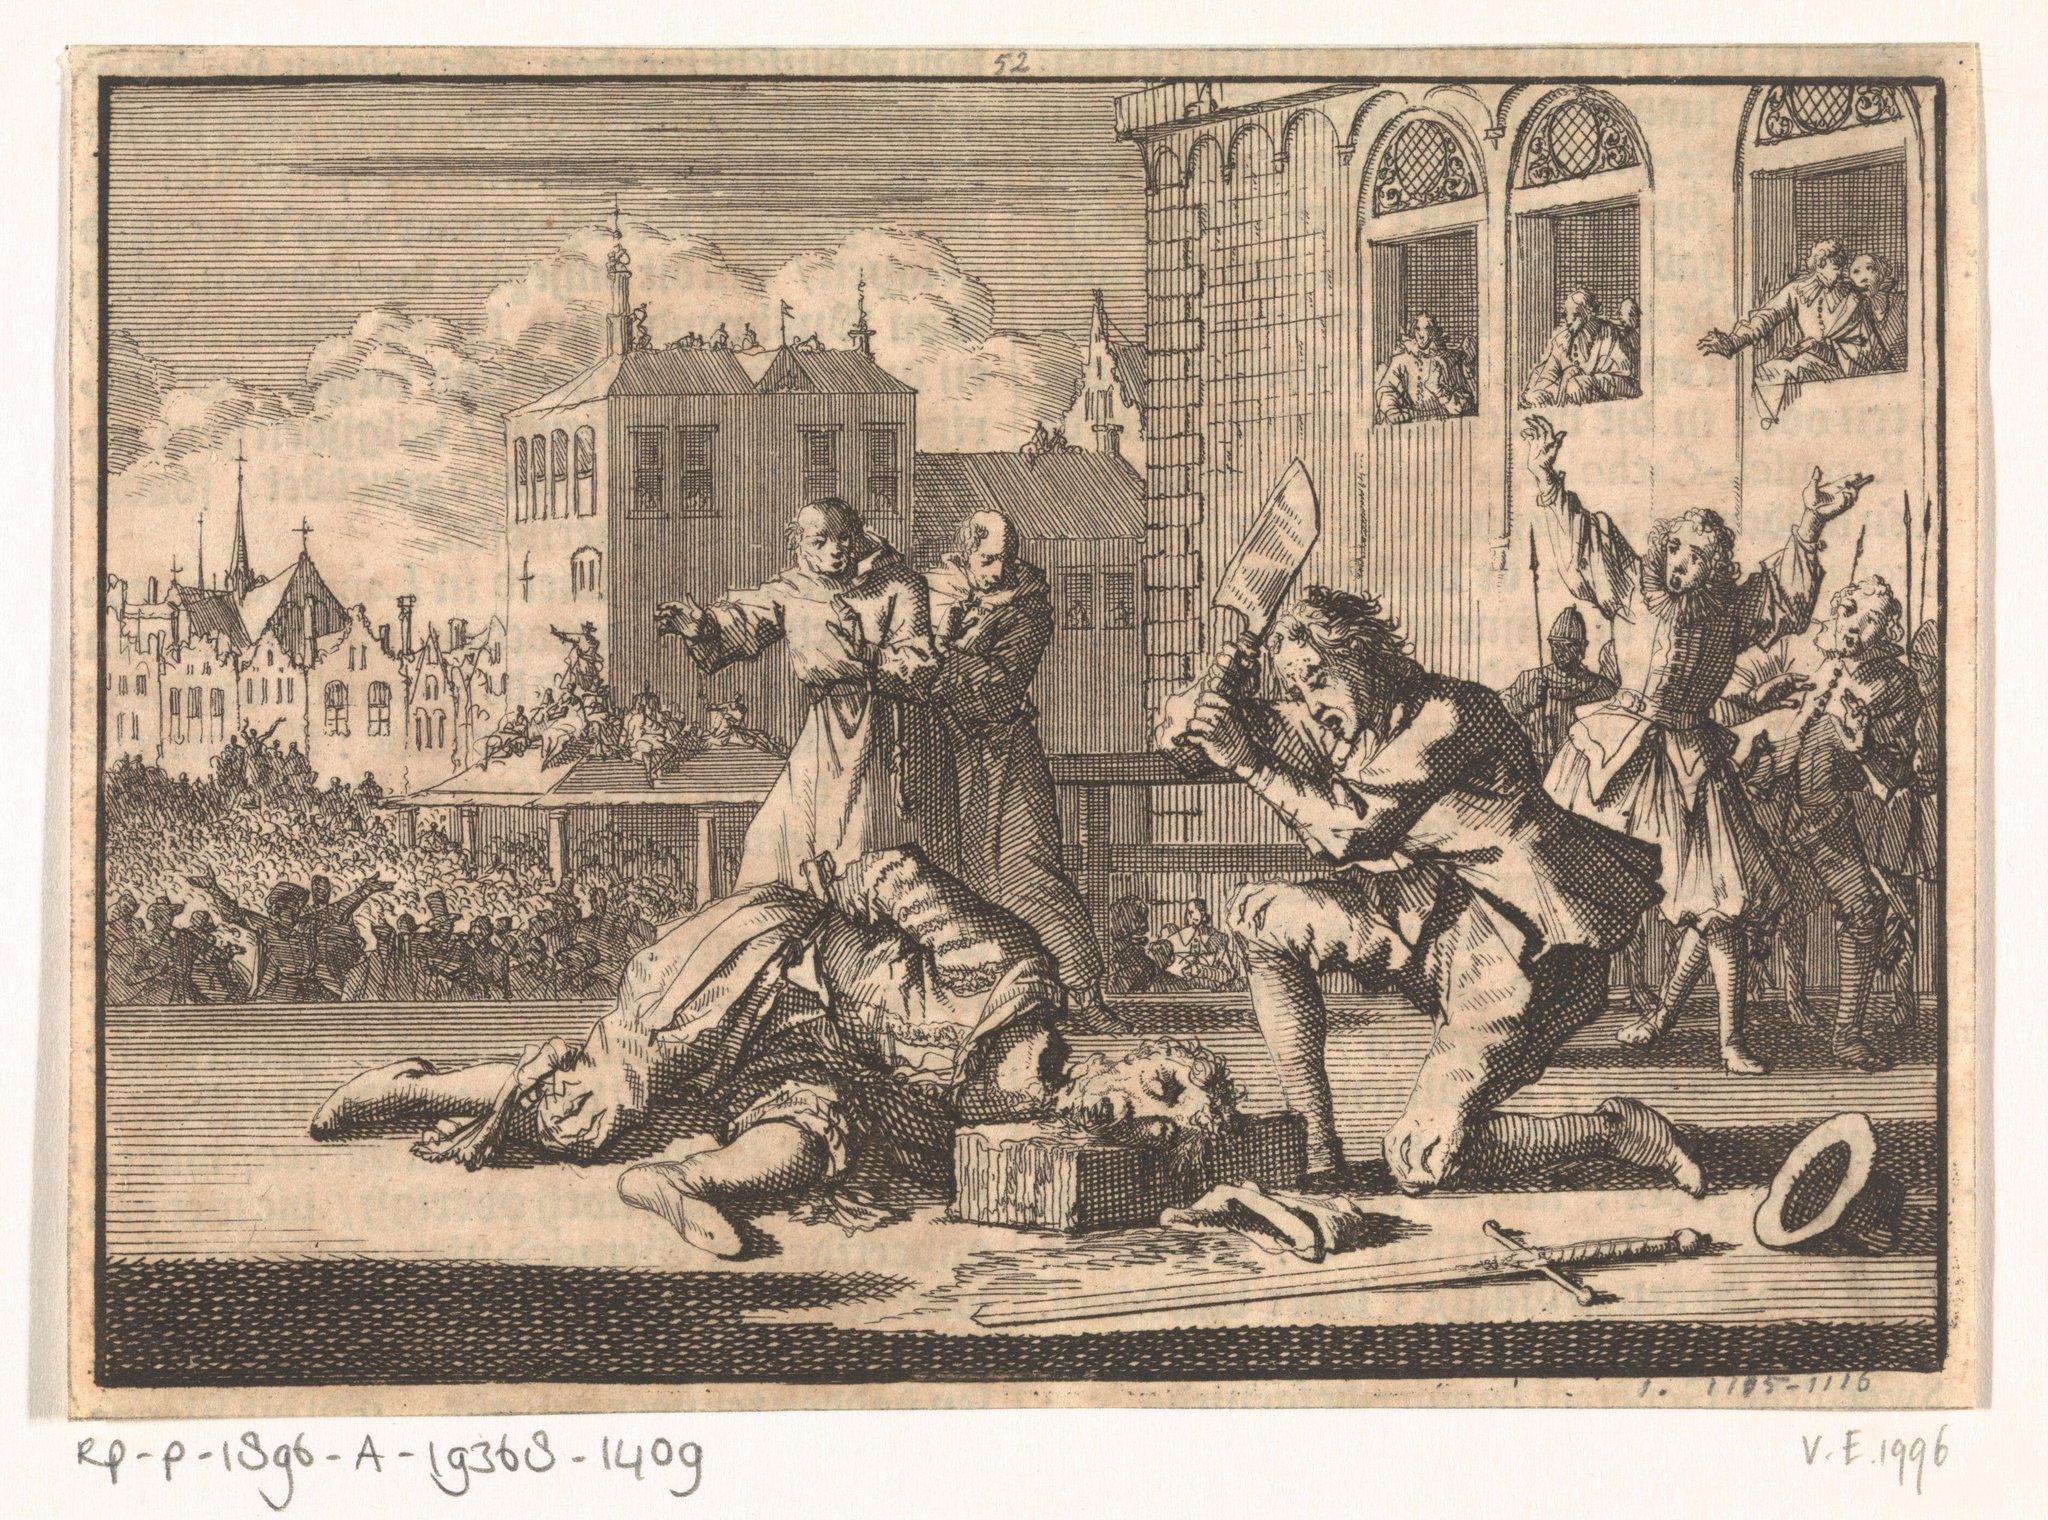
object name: book illustration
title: Onthoofding van Henri de Talleyrand-Périgord door een ongeoefende beul, 1626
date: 1698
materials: paper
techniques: etching, letterpress printing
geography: amsterdam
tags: violent death by beheading, executioner, hangman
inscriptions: collector's mark: Lugt 2228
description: Illustratie uit: Gottfried, Johann Ludwig. Historische kronyck; vervattende een (...) beschrijvingh der aldergedenckwaerdigste geschiedenissen des weerelds, van den aenvangh der scheppingh tot (...) 1576 (2 delen). Leiden: Pieter van der Aa, 1698, dl. I, p. 1115.